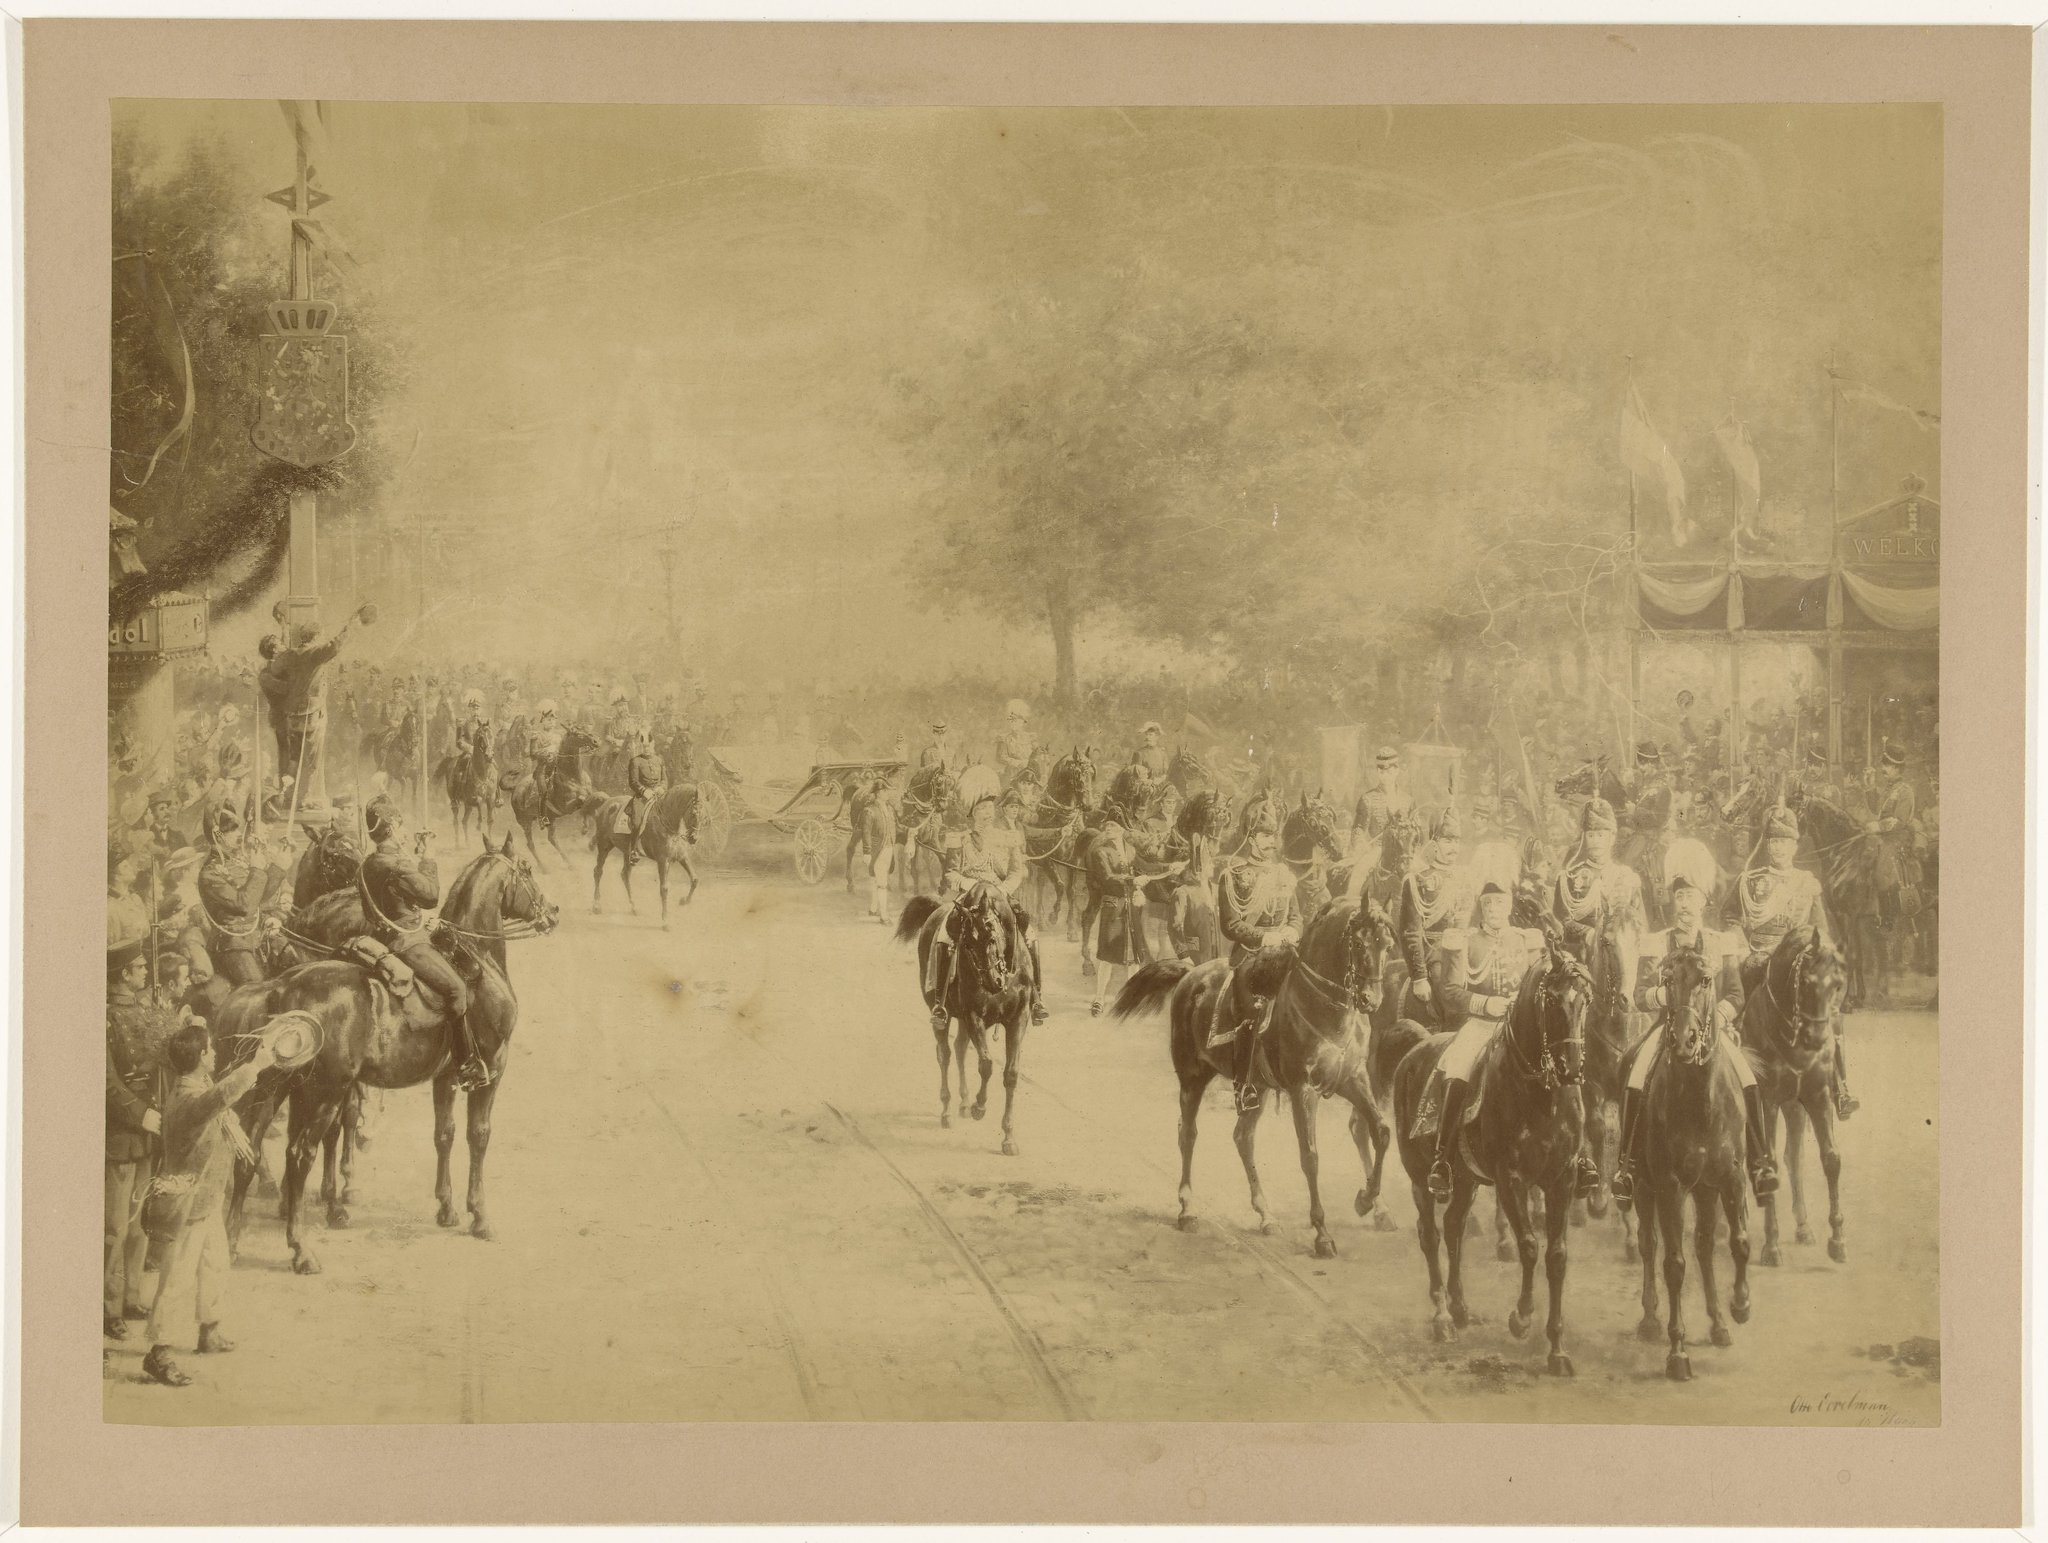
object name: photograph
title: Het Frederiksplein te Amsterdam tijdens de intocht van koningin Wilhelmina, 5 september 1898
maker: Anonymous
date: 1898-1915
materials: cardboard, photographic support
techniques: albumen print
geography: netherlands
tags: triumphal entry and public reception, pageant, 'entrée solennelle', 'joyeuse entrée'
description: Foto-reproductie van een schilderij van Otto Eerelman.